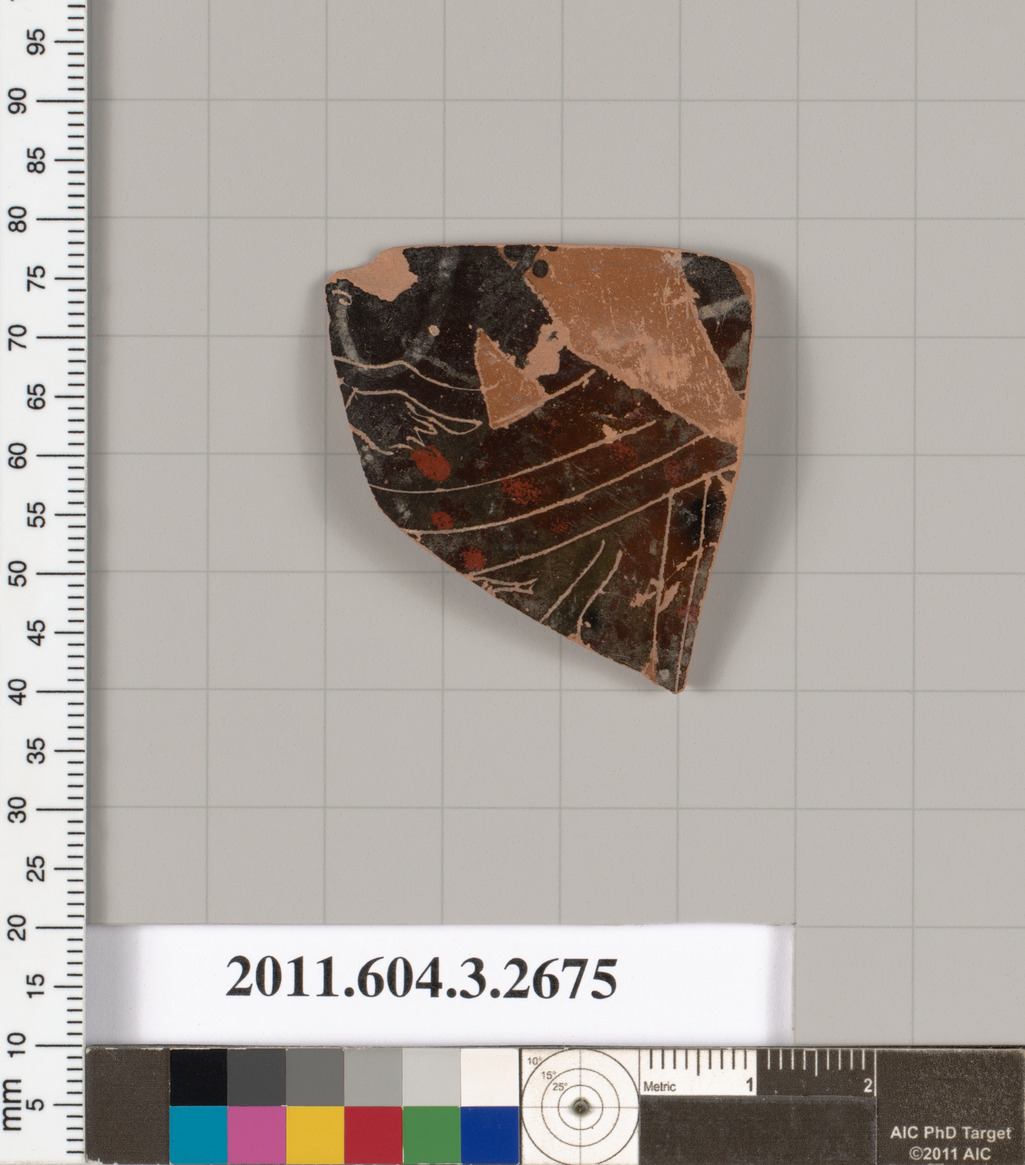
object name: oinochoe or olpe fragment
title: Terracotta fragment of an oinochoe (jug) or olpe (jug)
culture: greek, attic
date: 510-500 BCE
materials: terracotta